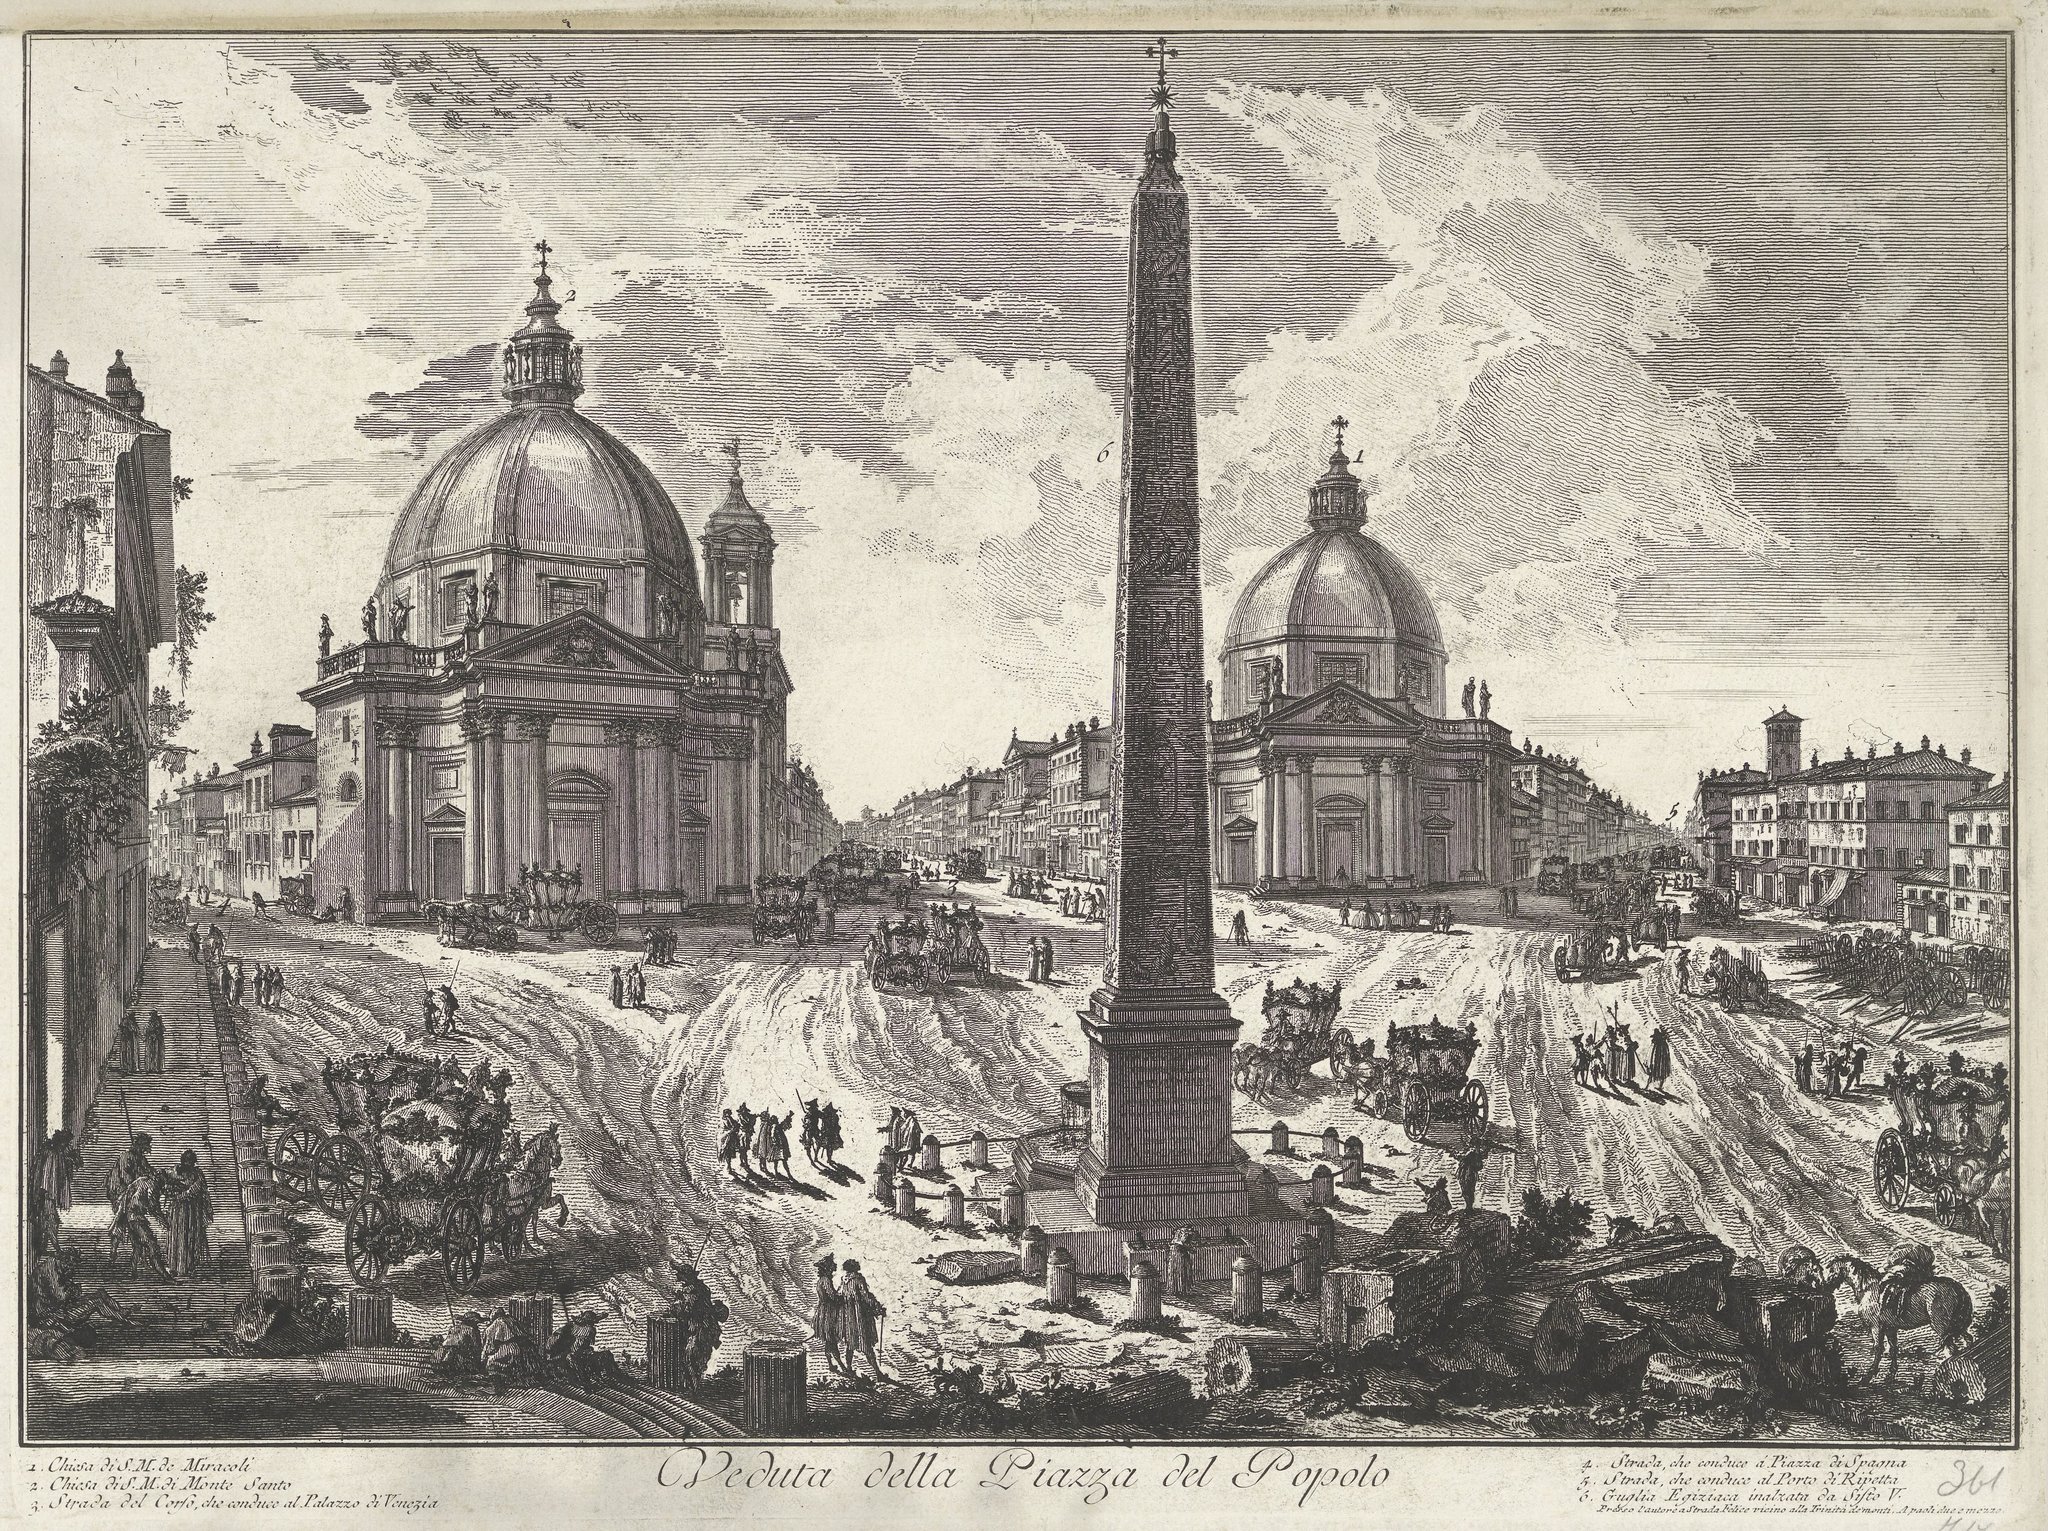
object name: print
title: Veduta della Piazza del Popolo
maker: giovanni battista piranesi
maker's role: designer, draughtsman, print maker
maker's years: 1720-1778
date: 1748-1778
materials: paper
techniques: etching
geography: rome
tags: square, place, circus, etc., obelisk, needle, church (exterior), roman catholic church, rome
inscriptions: collector's mark: Lugt 2228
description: Deze prent maakt deel uit van de serie 'Vedute di Roma'. Piranesi werkte aan deze 135 platen tellende serie tussen 1748 en zijn dood in 1778. Francesco Piranesi voegde later nog twee prenten toe aan de reeks van zijn vader.